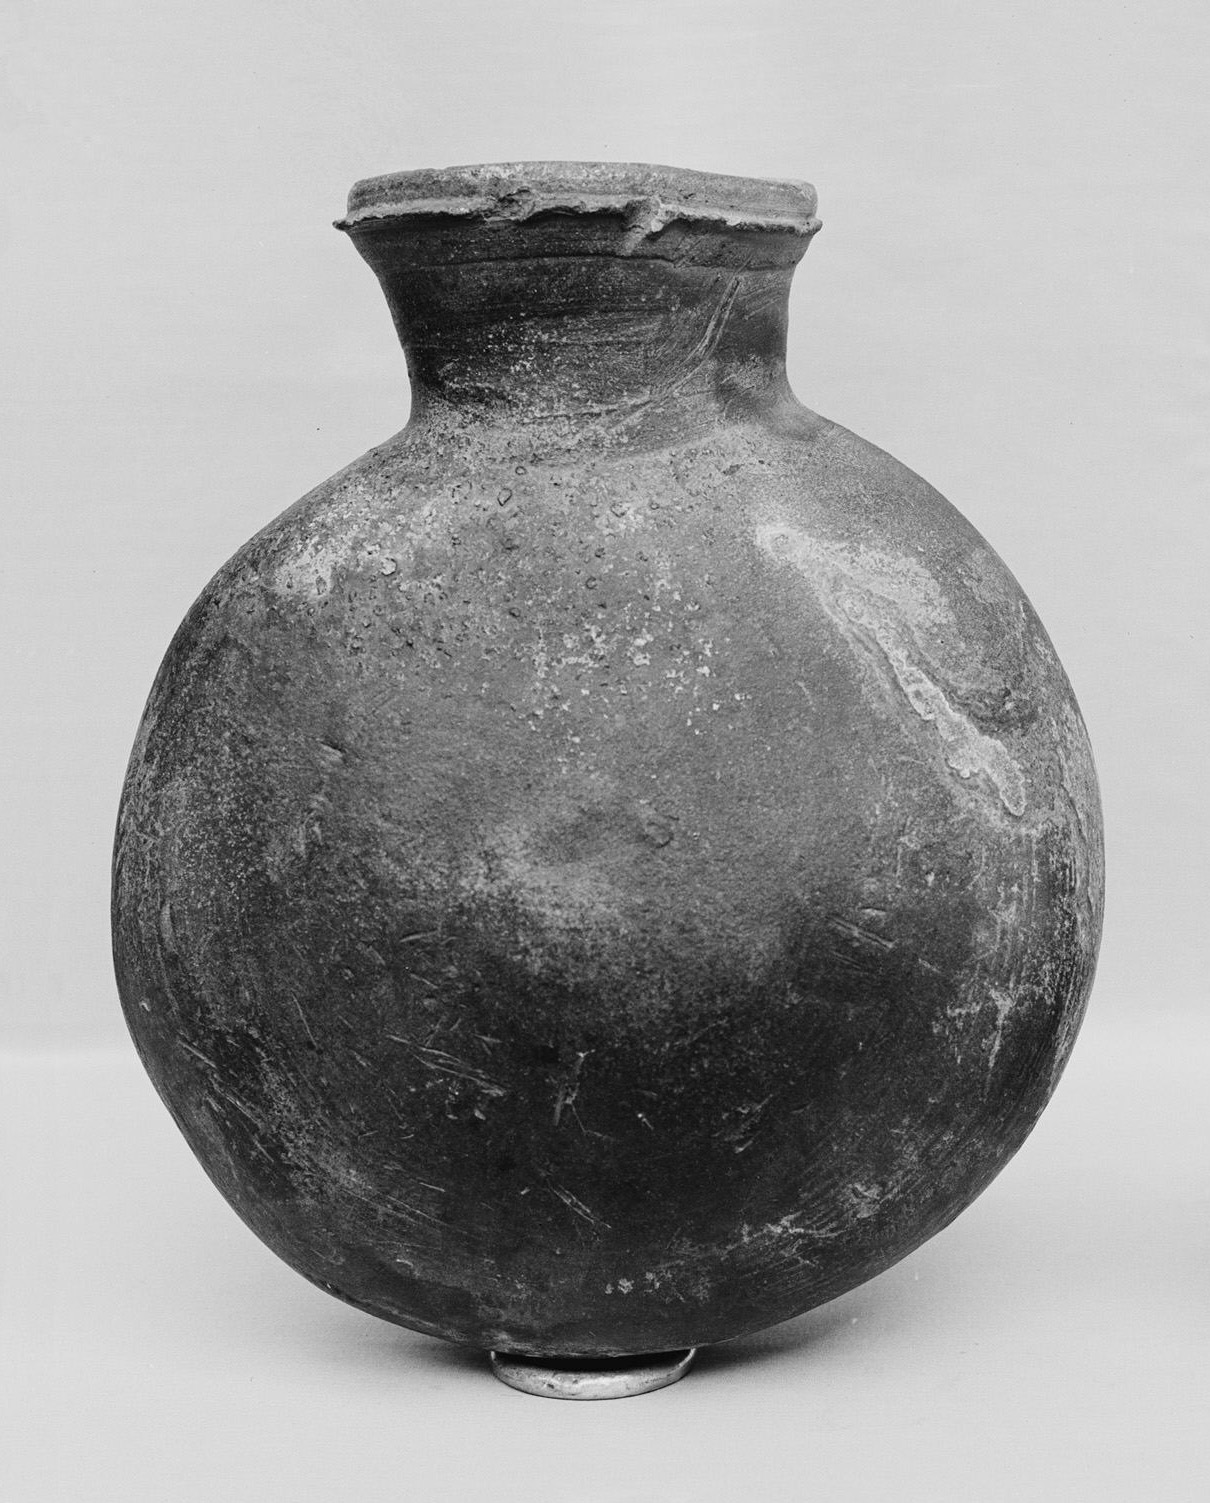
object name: jug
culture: japanese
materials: stoneware